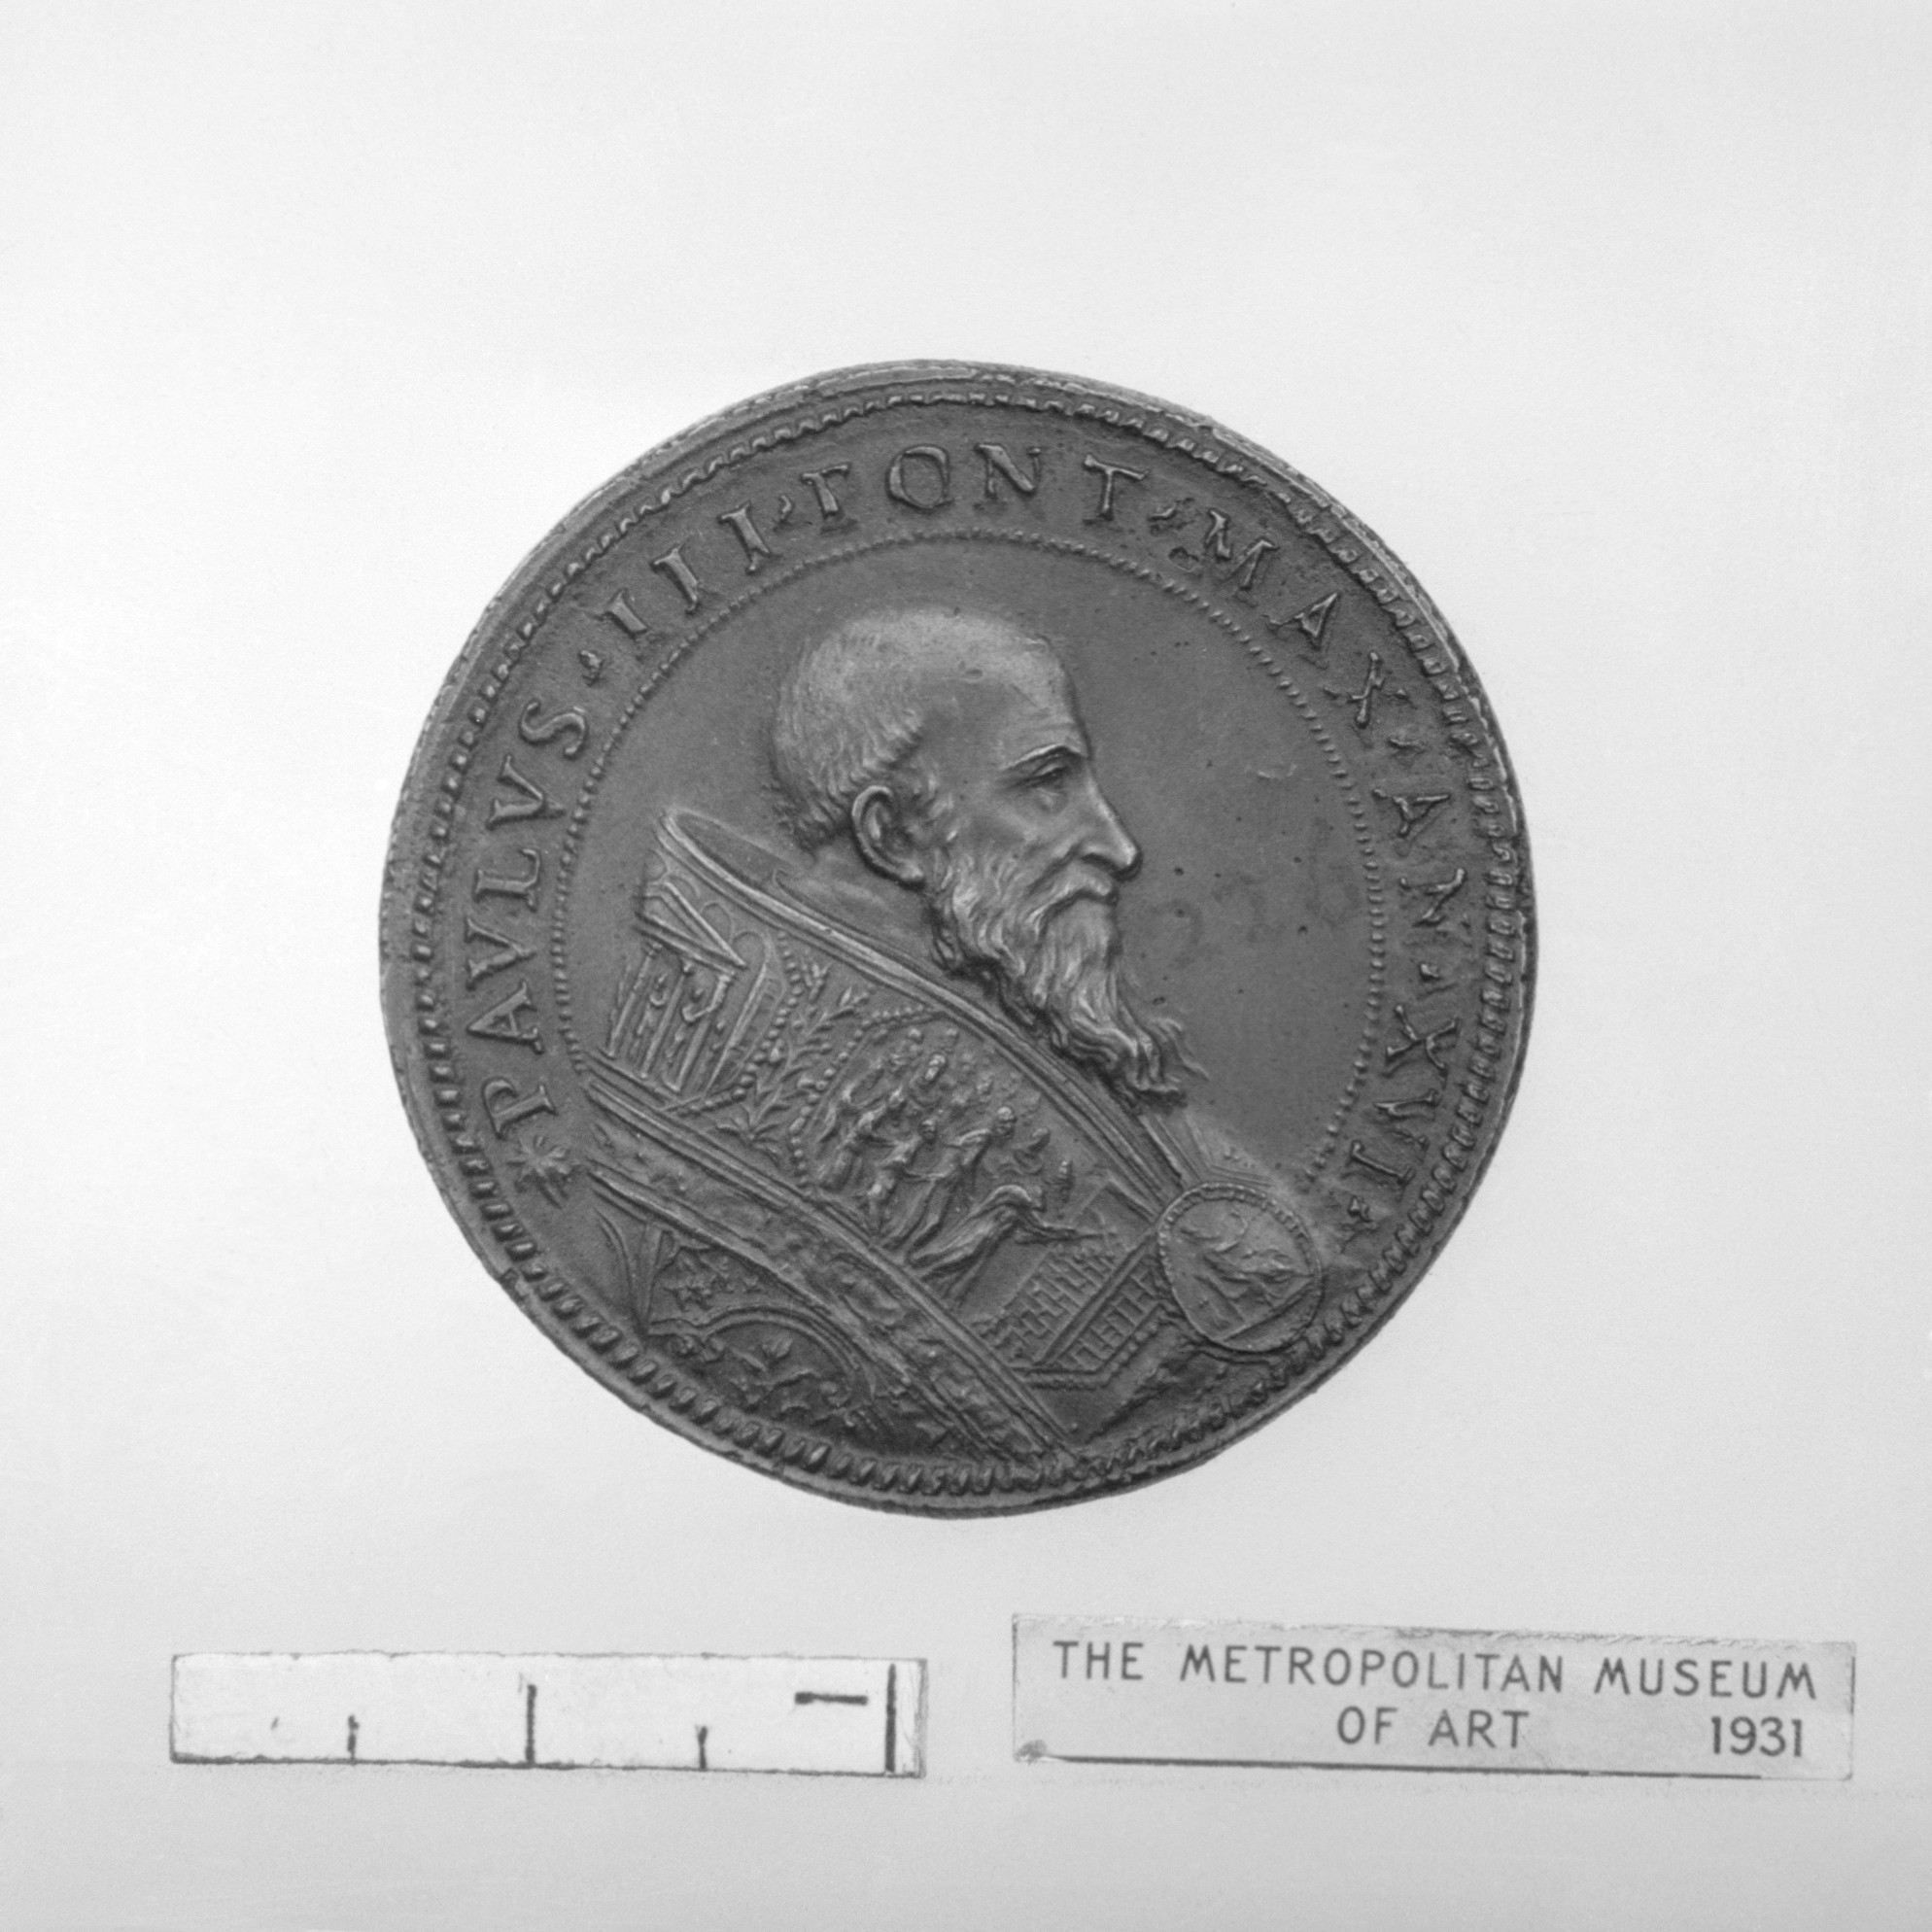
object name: medal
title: Pope Paul III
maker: alessandro cesati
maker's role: artist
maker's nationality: italian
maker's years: 1538-1564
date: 1501-1600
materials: bronze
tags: men,profiles